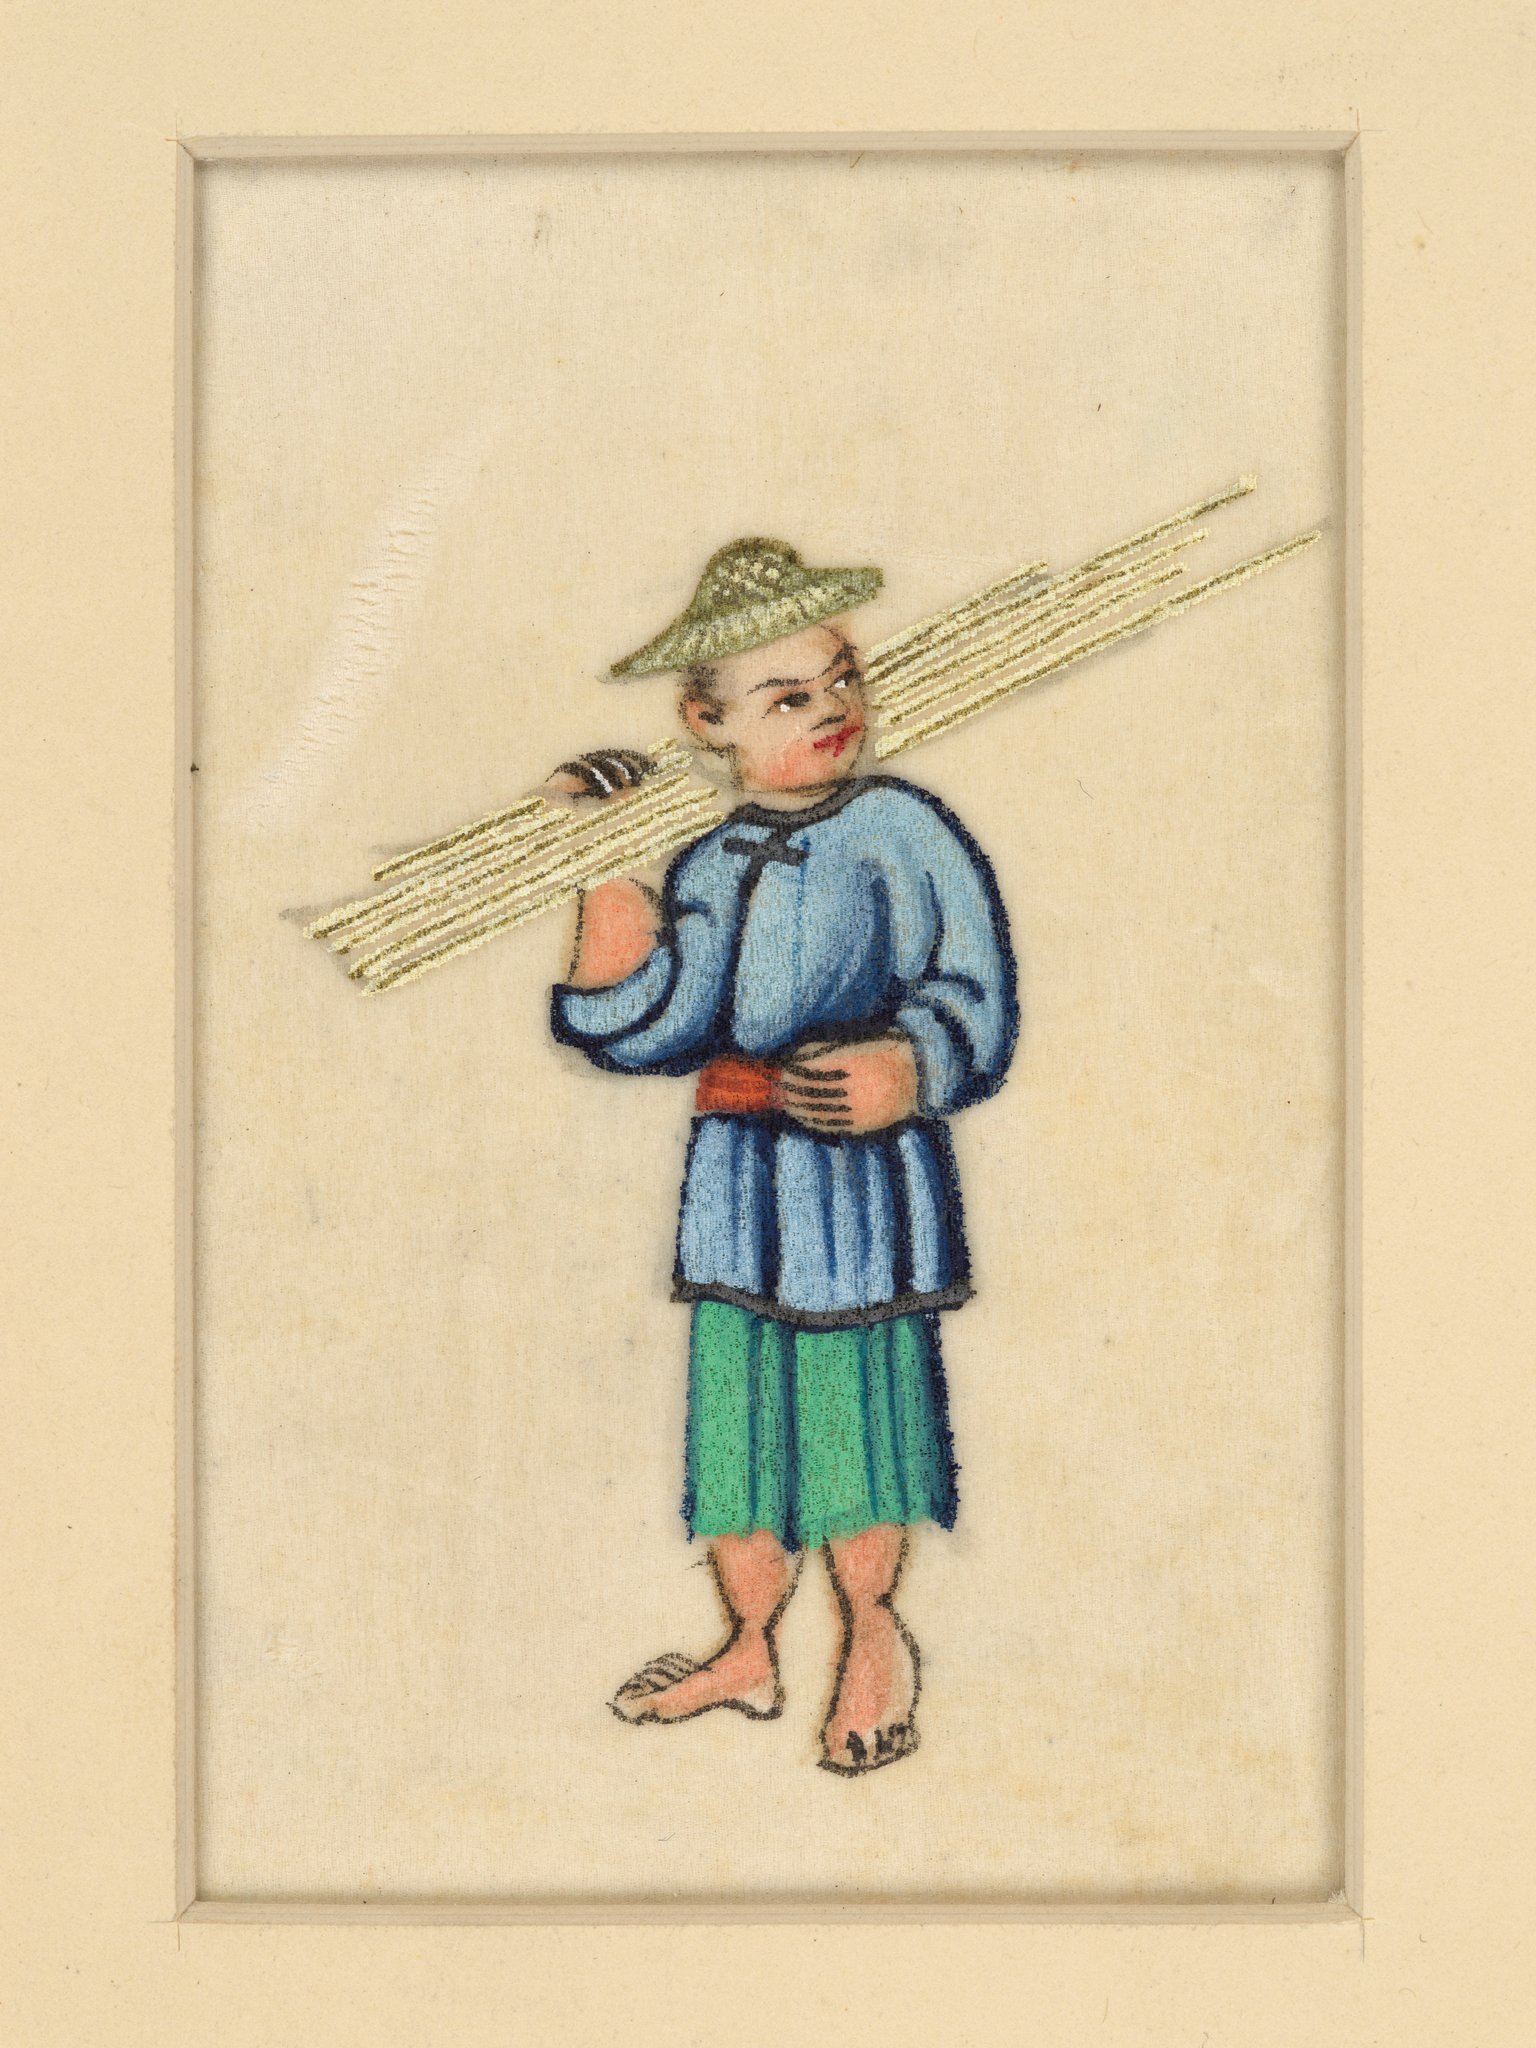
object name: leaf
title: Man Carrying Tiger's Tails in Procession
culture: chinese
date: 1901-1933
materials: paper